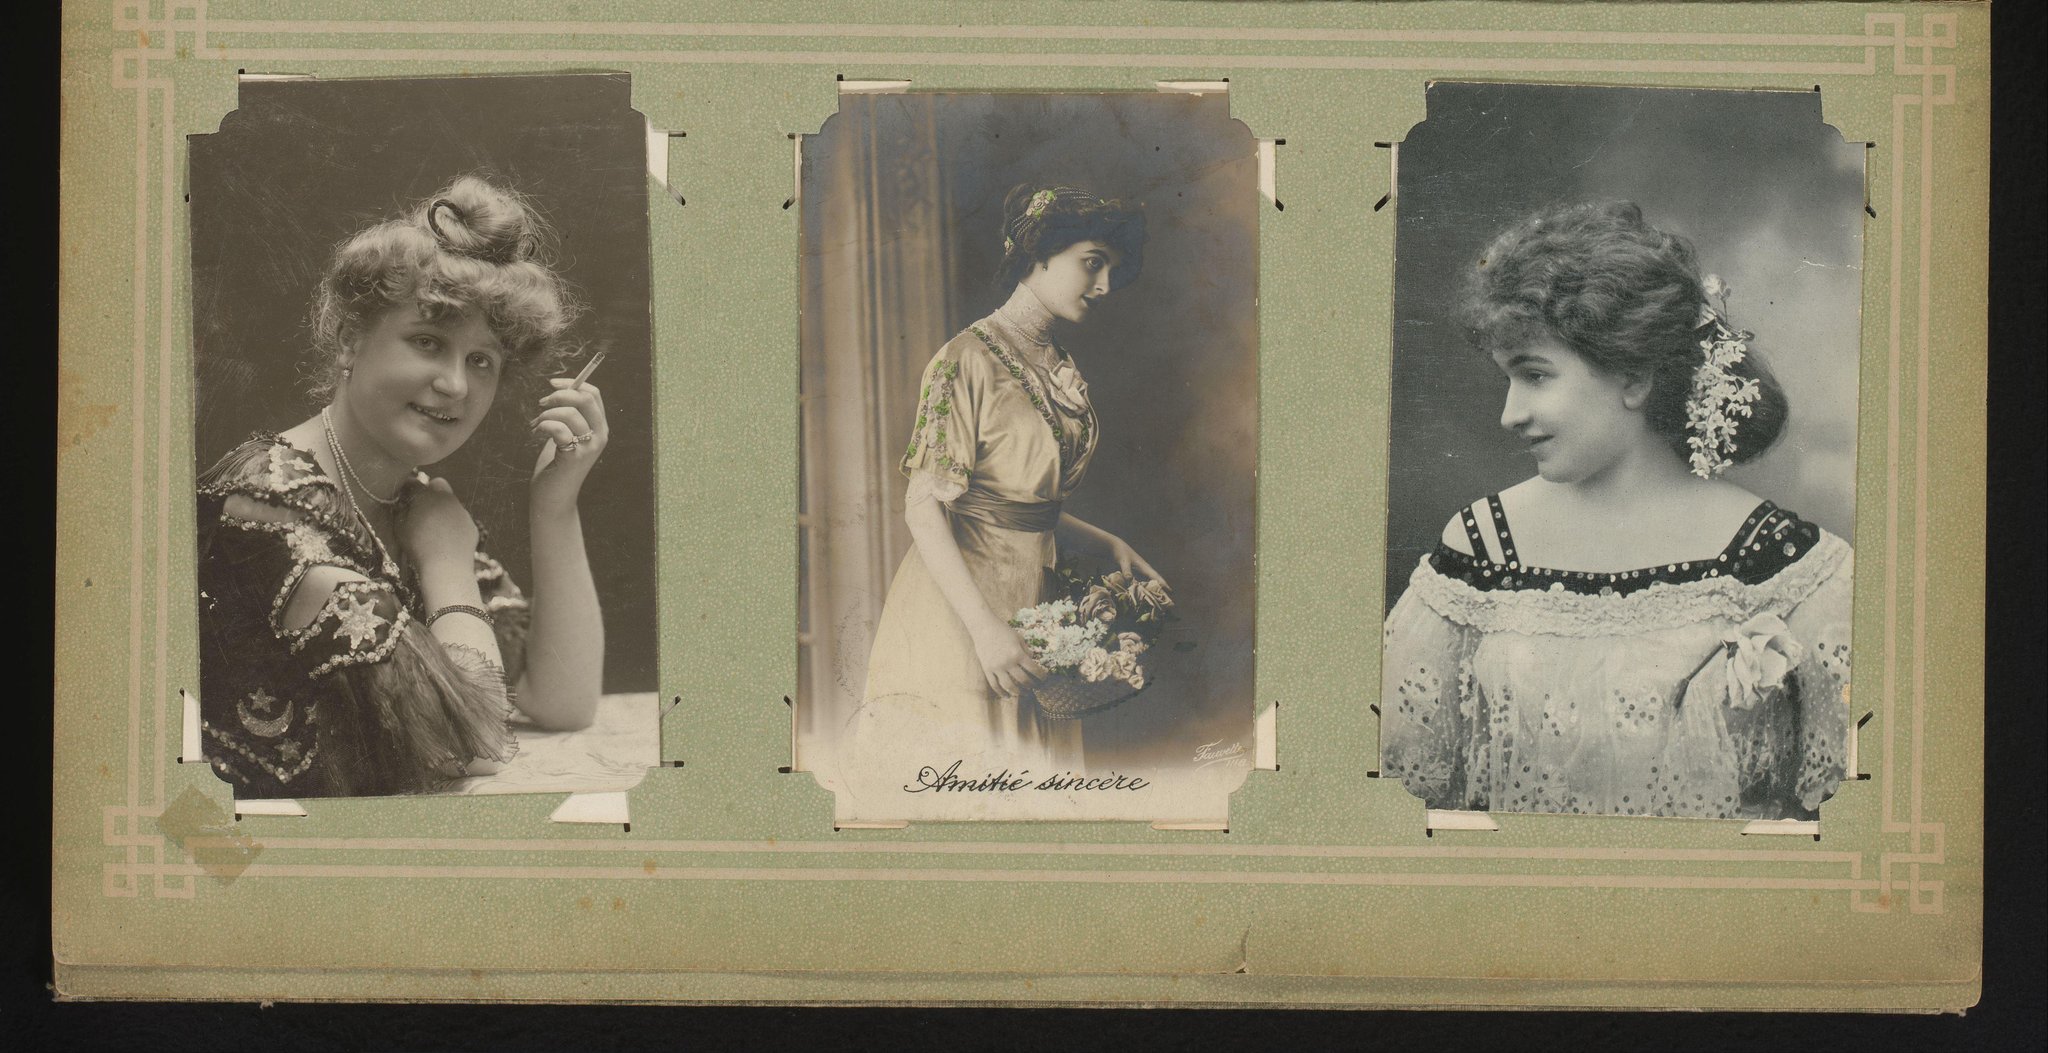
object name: album leaf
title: Drie portretten van vrouwen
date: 1900-1930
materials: cardboard, ink, photographic support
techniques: gelatin silver print, hand coloring, pen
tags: historical persons - bb - woman, portrait of actor, actress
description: Deze foto's en prent maken deel uit van een album.